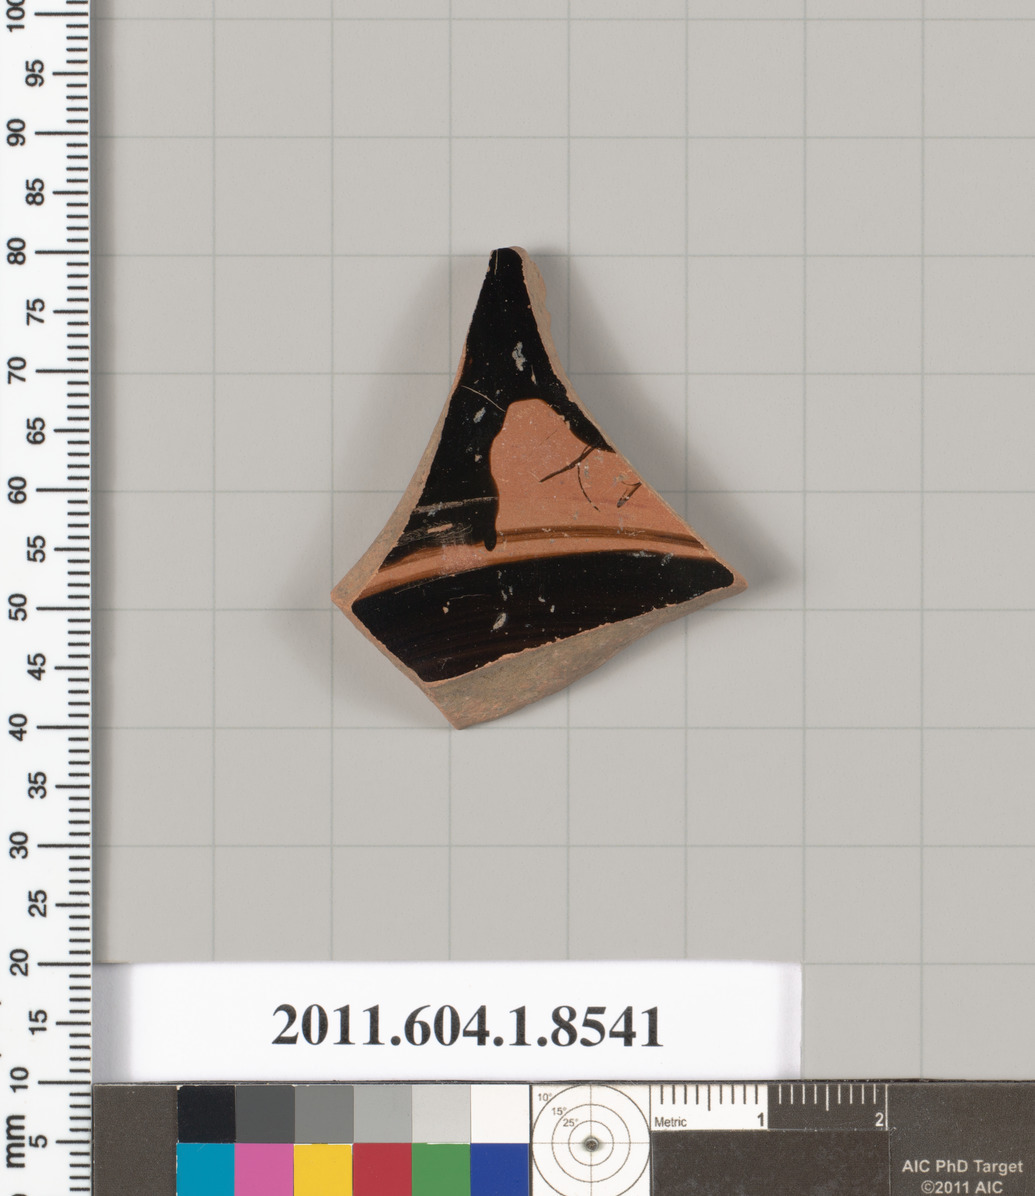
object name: kylix fragment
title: Terracotta fragment of a stemless kylix (drinking cup)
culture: greek, attic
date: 467-435 BCE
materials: terracotta